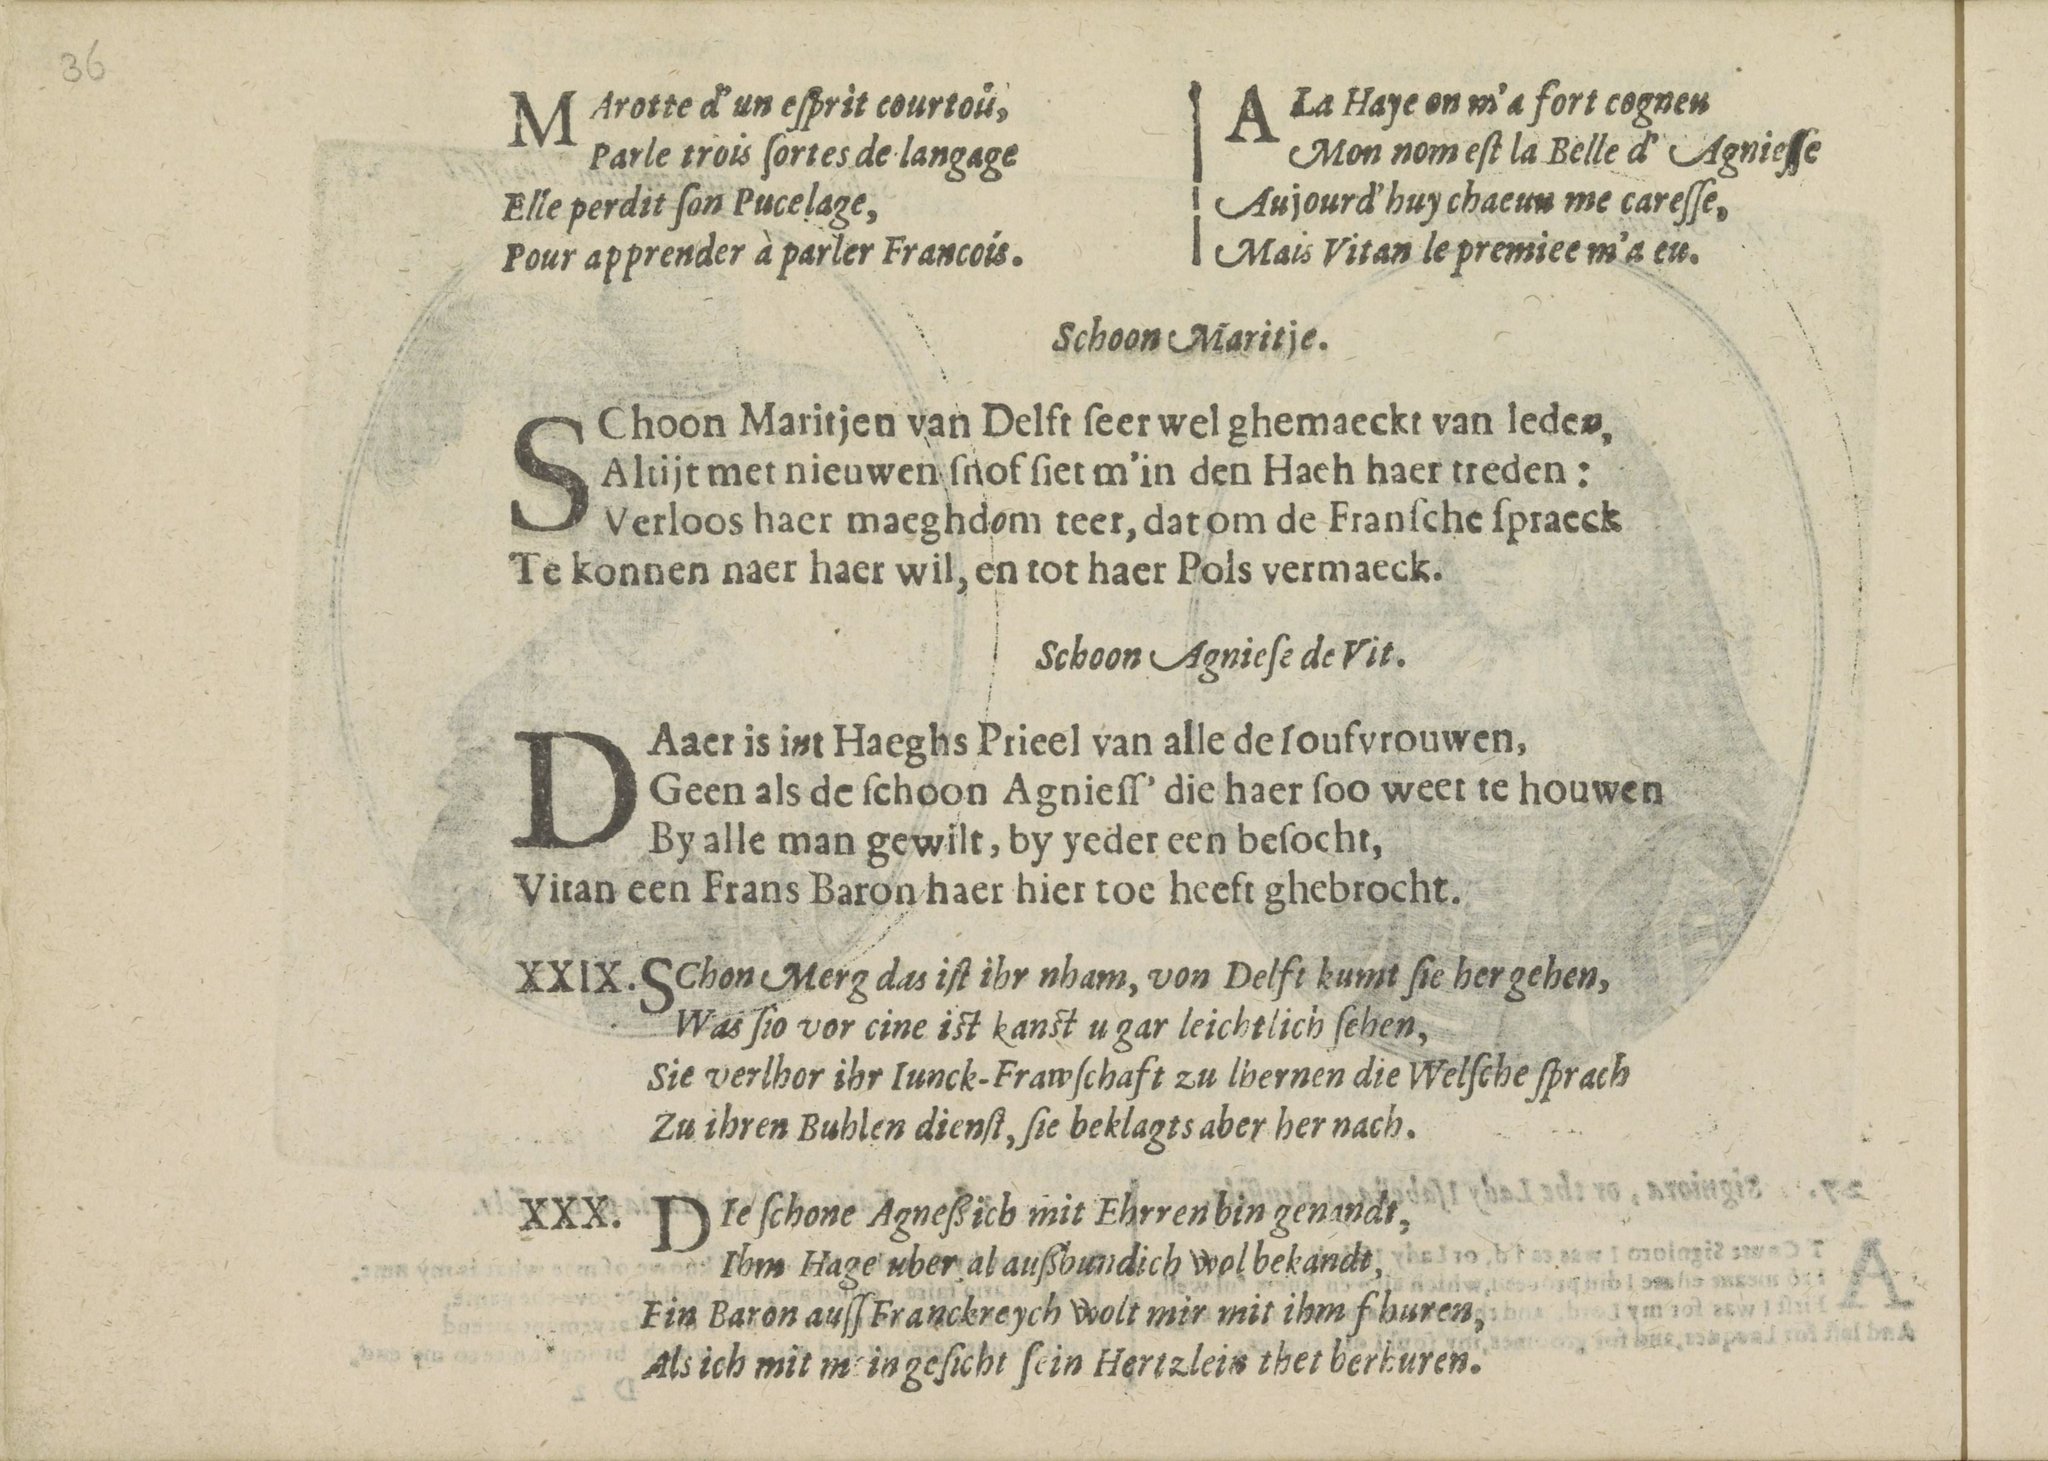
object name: album leaf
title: Miroir des plus belles courtisanes de ce temps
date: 1635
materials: paper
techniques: letterpress printing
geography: utrecht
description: Drie keer twee kwatrijnen in het Frans, Nederlands en Duits bij de portretten van de courtisanes genaamd Schone Maritje en Schone Angiese (Agnes) de Vit. Het blad maakt deel uit van een album.